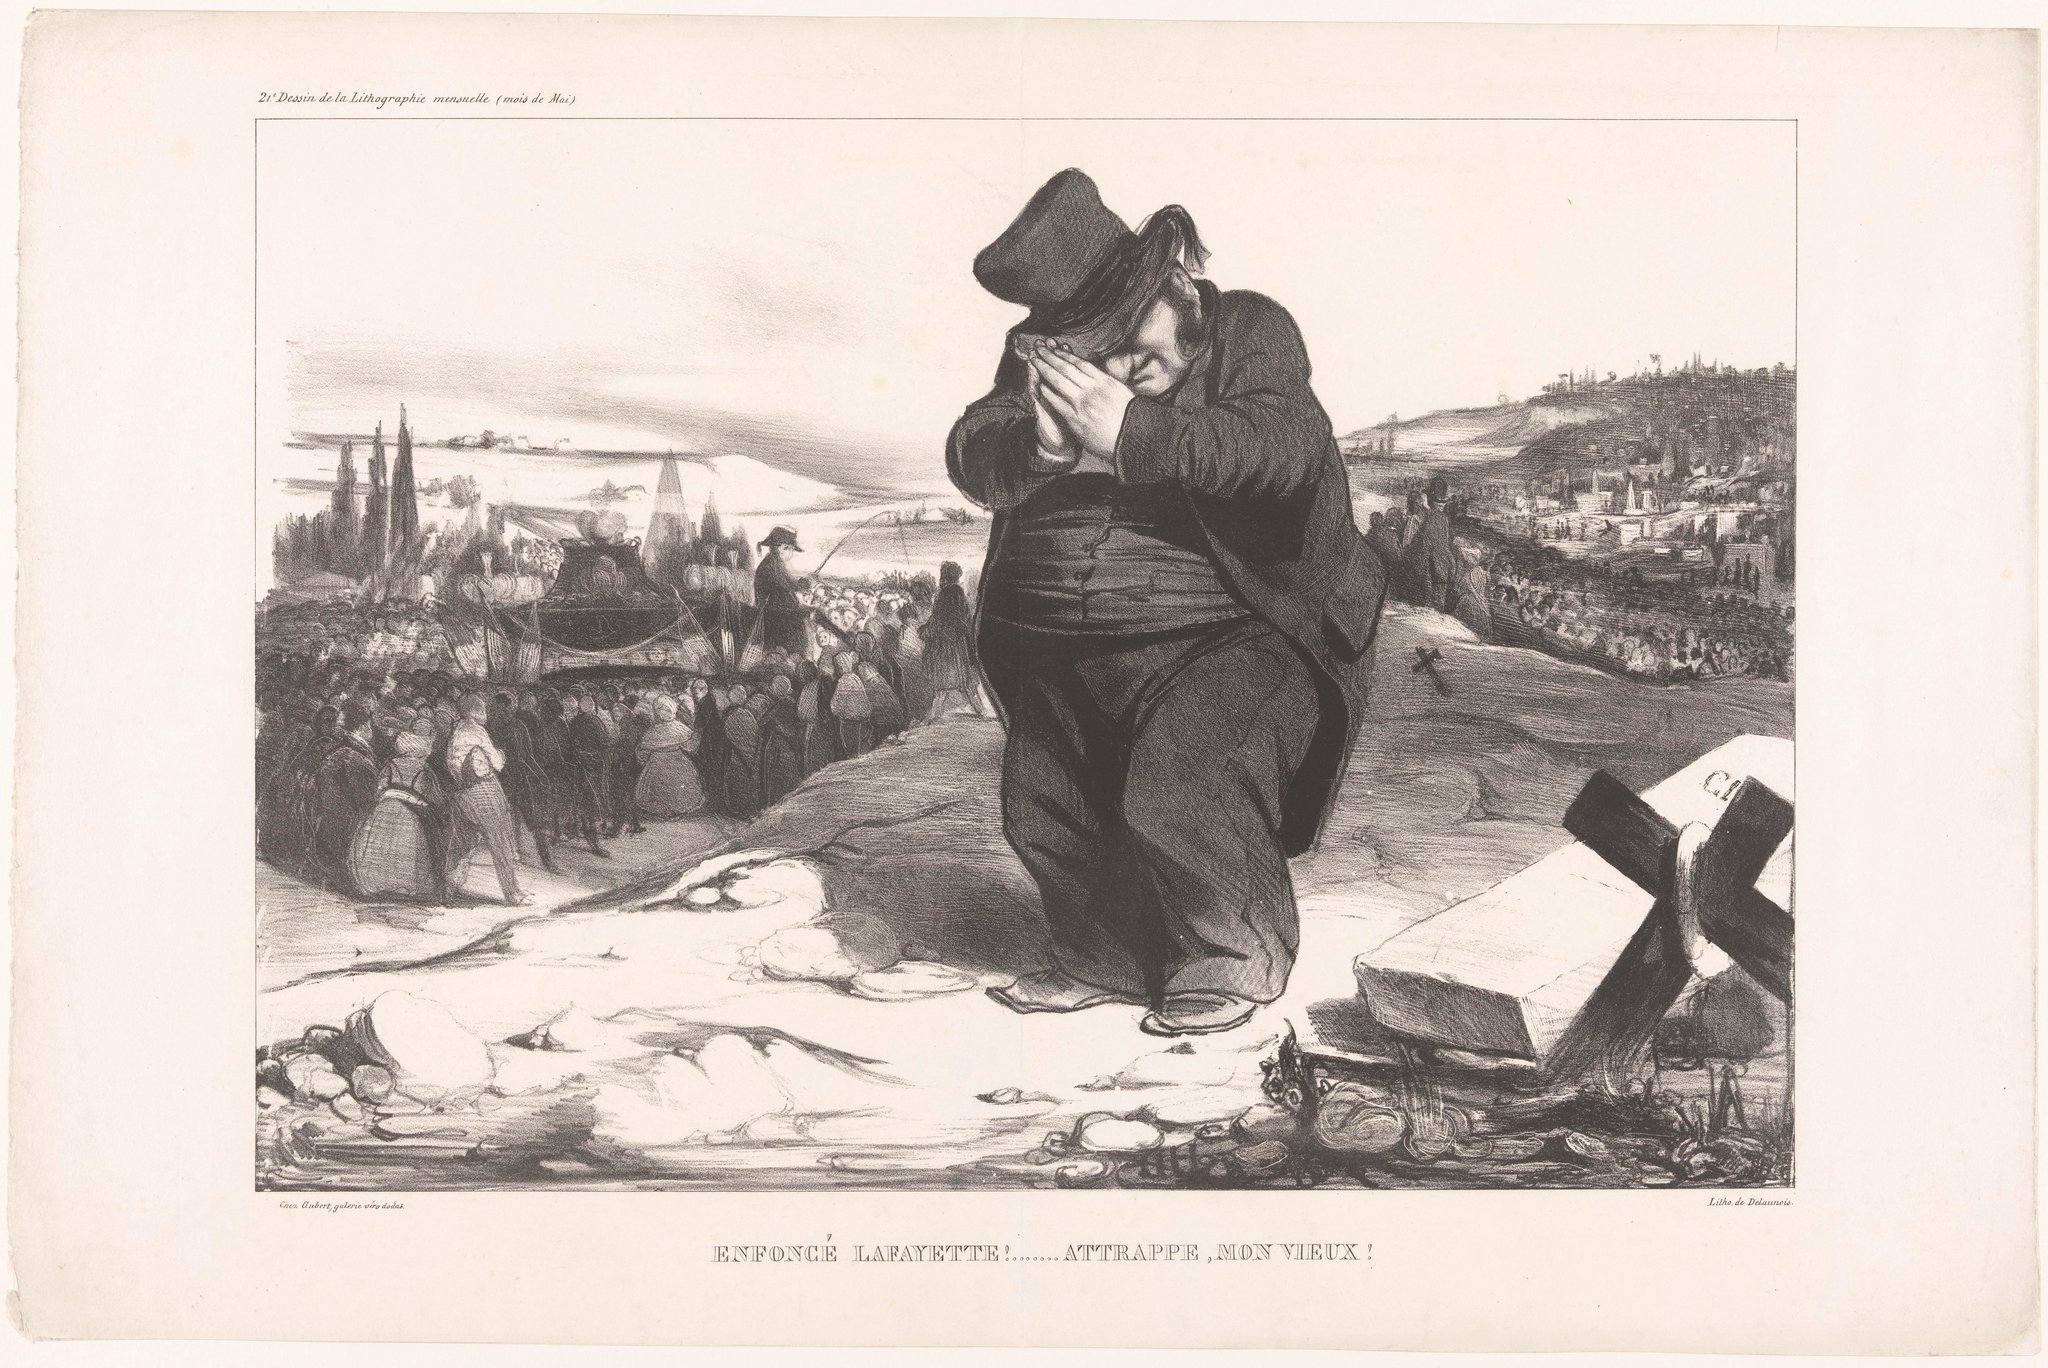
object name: print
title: Enfoncé Lafayette!... Attrappe, mon vieux!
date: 1834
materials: paper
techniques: lithograph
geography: paris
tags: politician, paris, lodewijk filips i (koning van frankrijk), caricatures (human types), historical persons, cortege, funeral procession, political caricatures and satires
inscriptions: collector's mark: Lugt 2228a, collector's mark: Lugt 2760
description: De Franse koning heeft zich verkleed als begrafenisondernemer tijdens de begrafenis van Marquis de La Fayette.